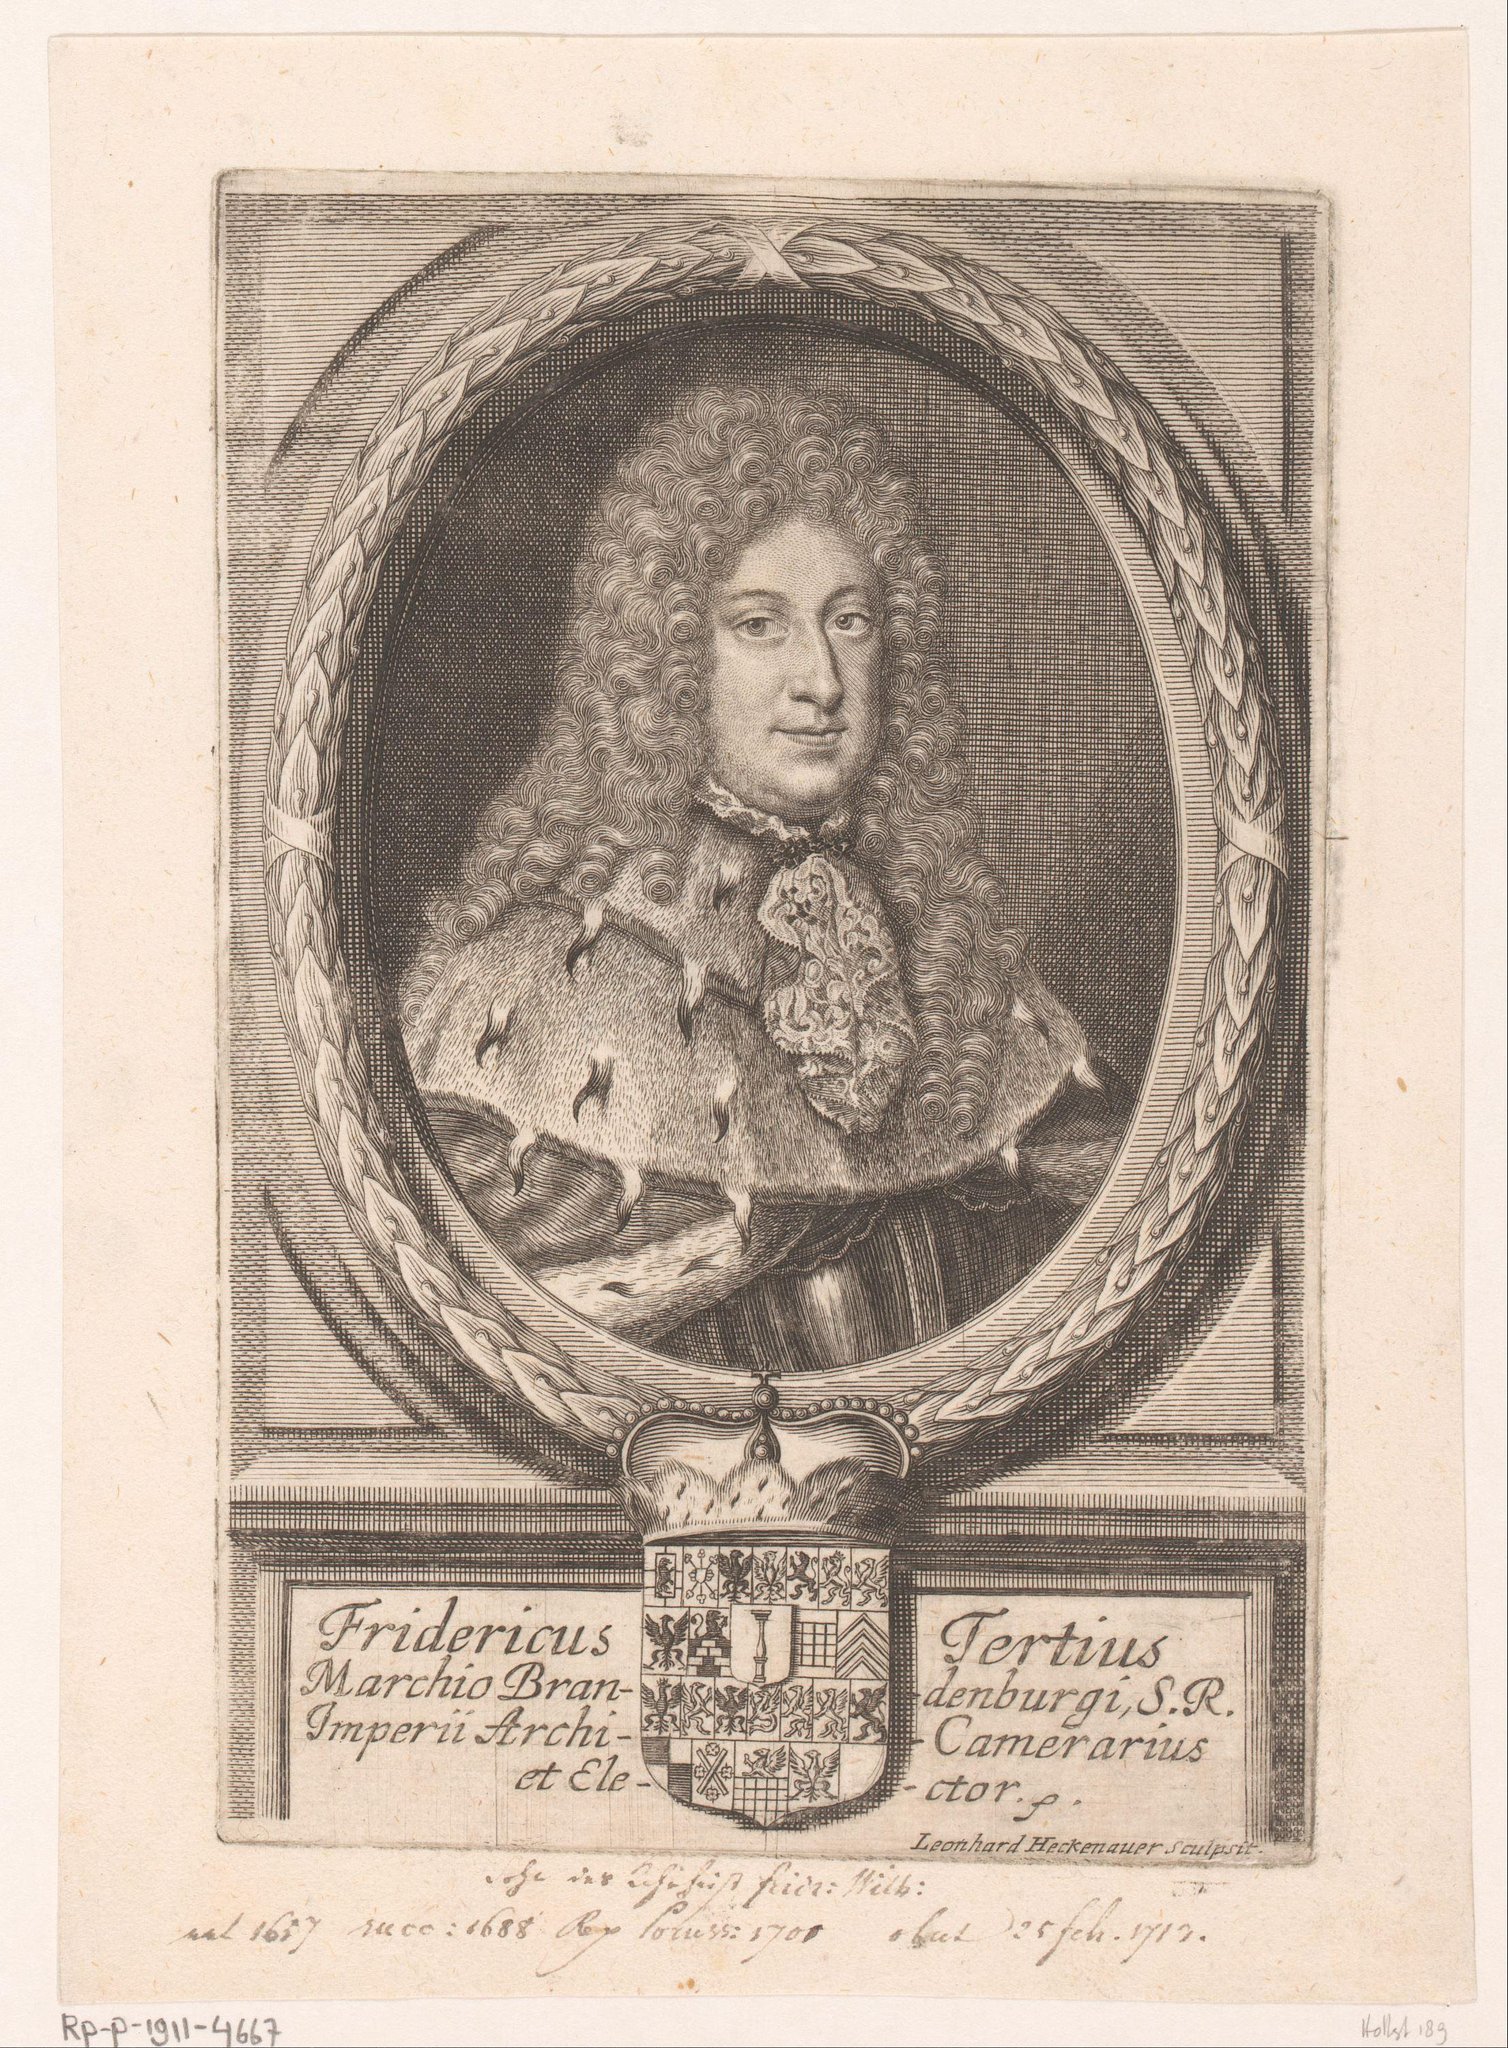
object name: print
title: Portret van Frederik I, koning van Pruisen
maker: leonhard heckenauer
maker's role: print maker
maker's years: 1650-1704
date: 1690-1697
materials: paper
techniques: engraving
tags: berlin, frederik i koning van pruisen, trees: laurel (branch, stick), historical persons, mantle, gown, dress (symbol of sovereignty), armorial bearing, heraldry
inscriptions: collector's mark: Lugt 2228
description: Prent gebruikt voor: Thucelius, Christian Leonhard. Austria S.R.Imperio Conjux (...). Augsburg: Lorenz Kroniger, [1690]. Of prent gebruikt voor: Thulemarius, Heinrich Günther. Tractatio de Bulla aurea, argentea, plumbea et cerea in genere, nec non in specie de Aurea Bulla Caroli IV Imperatoris (...). Frankfurt am Main: Johann Melchior Bencard, 1697.